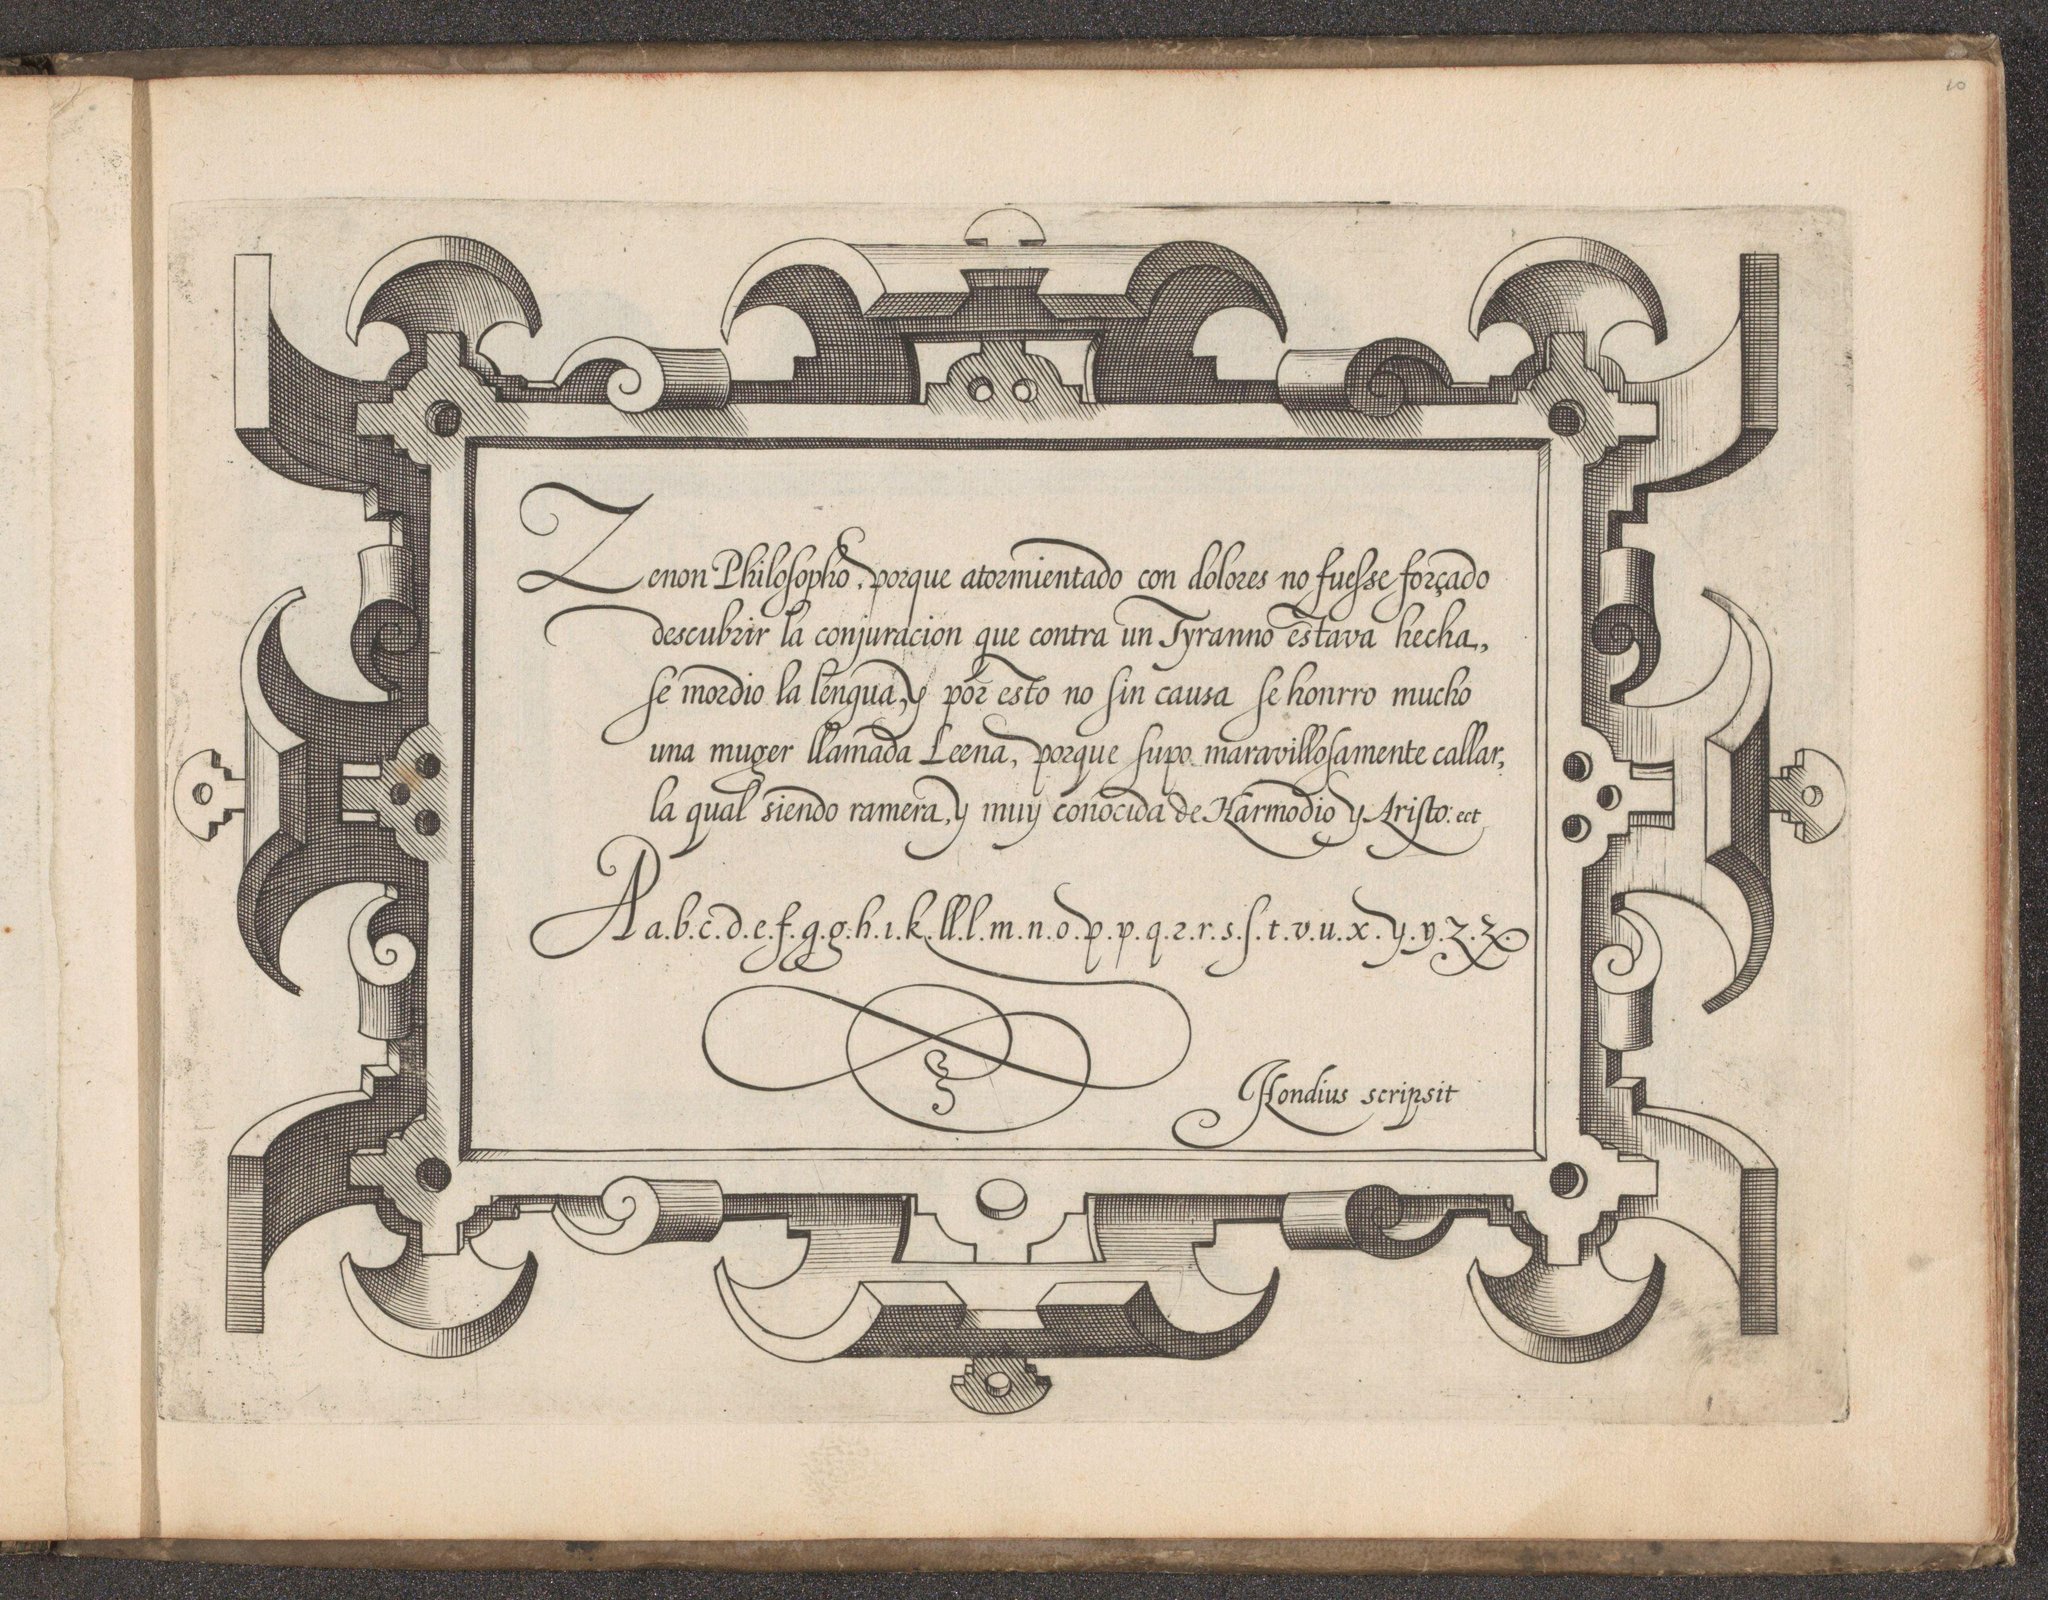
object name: album leaf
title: Theatrum artis scribendi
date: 1614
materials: paper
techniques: engraving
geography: amsterdam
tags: scrollwork, strapwork ~ ornament, ornament ~ cartouche, calligraphy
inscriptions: signature and date: ‘Op titelblad: Judoco Hondio celatore. Amstelodami apud Joannem Janssonium. 1614’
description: Schrijfvoorbeeld in een gotische hand met een vijf regels tekst in het Spaans. Onderaan een onderkastalfabet in de betreffende hand. Het voorbeeld is gevat in een rolwerkcartouche. De prent maakt deel uit van een album.